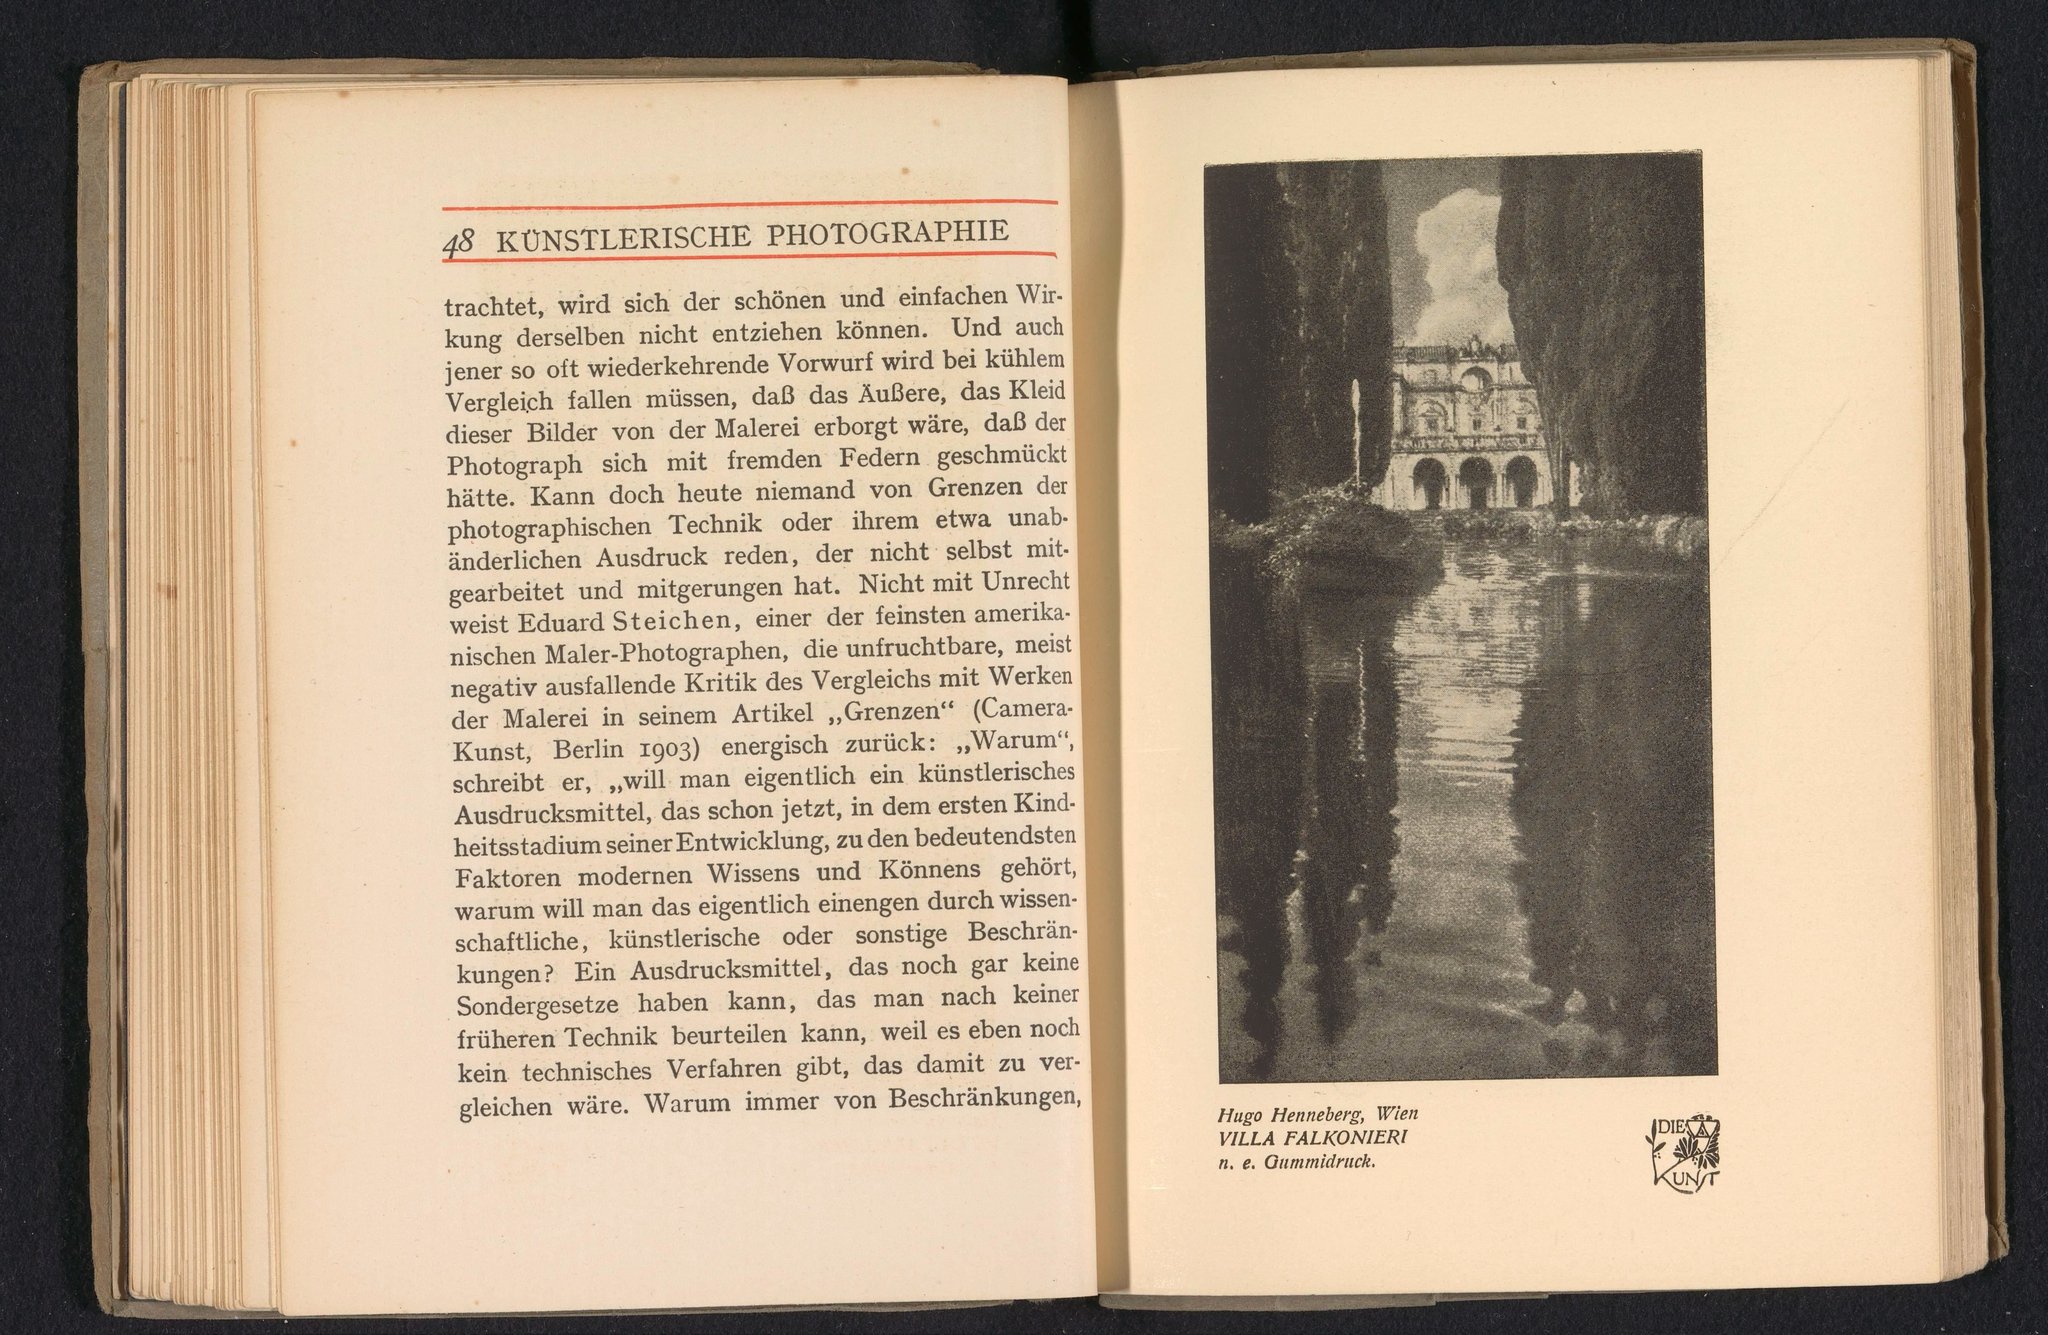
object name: photomechanical print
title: Fotoreproductie van een foto door Hugo Henneberg, voorstellend een gezicht op Villa Falconieri in Frascati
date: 1880-1907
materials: paper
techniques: autotype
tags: villa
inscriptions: inscription: ‘n.e. Gummidruck.’